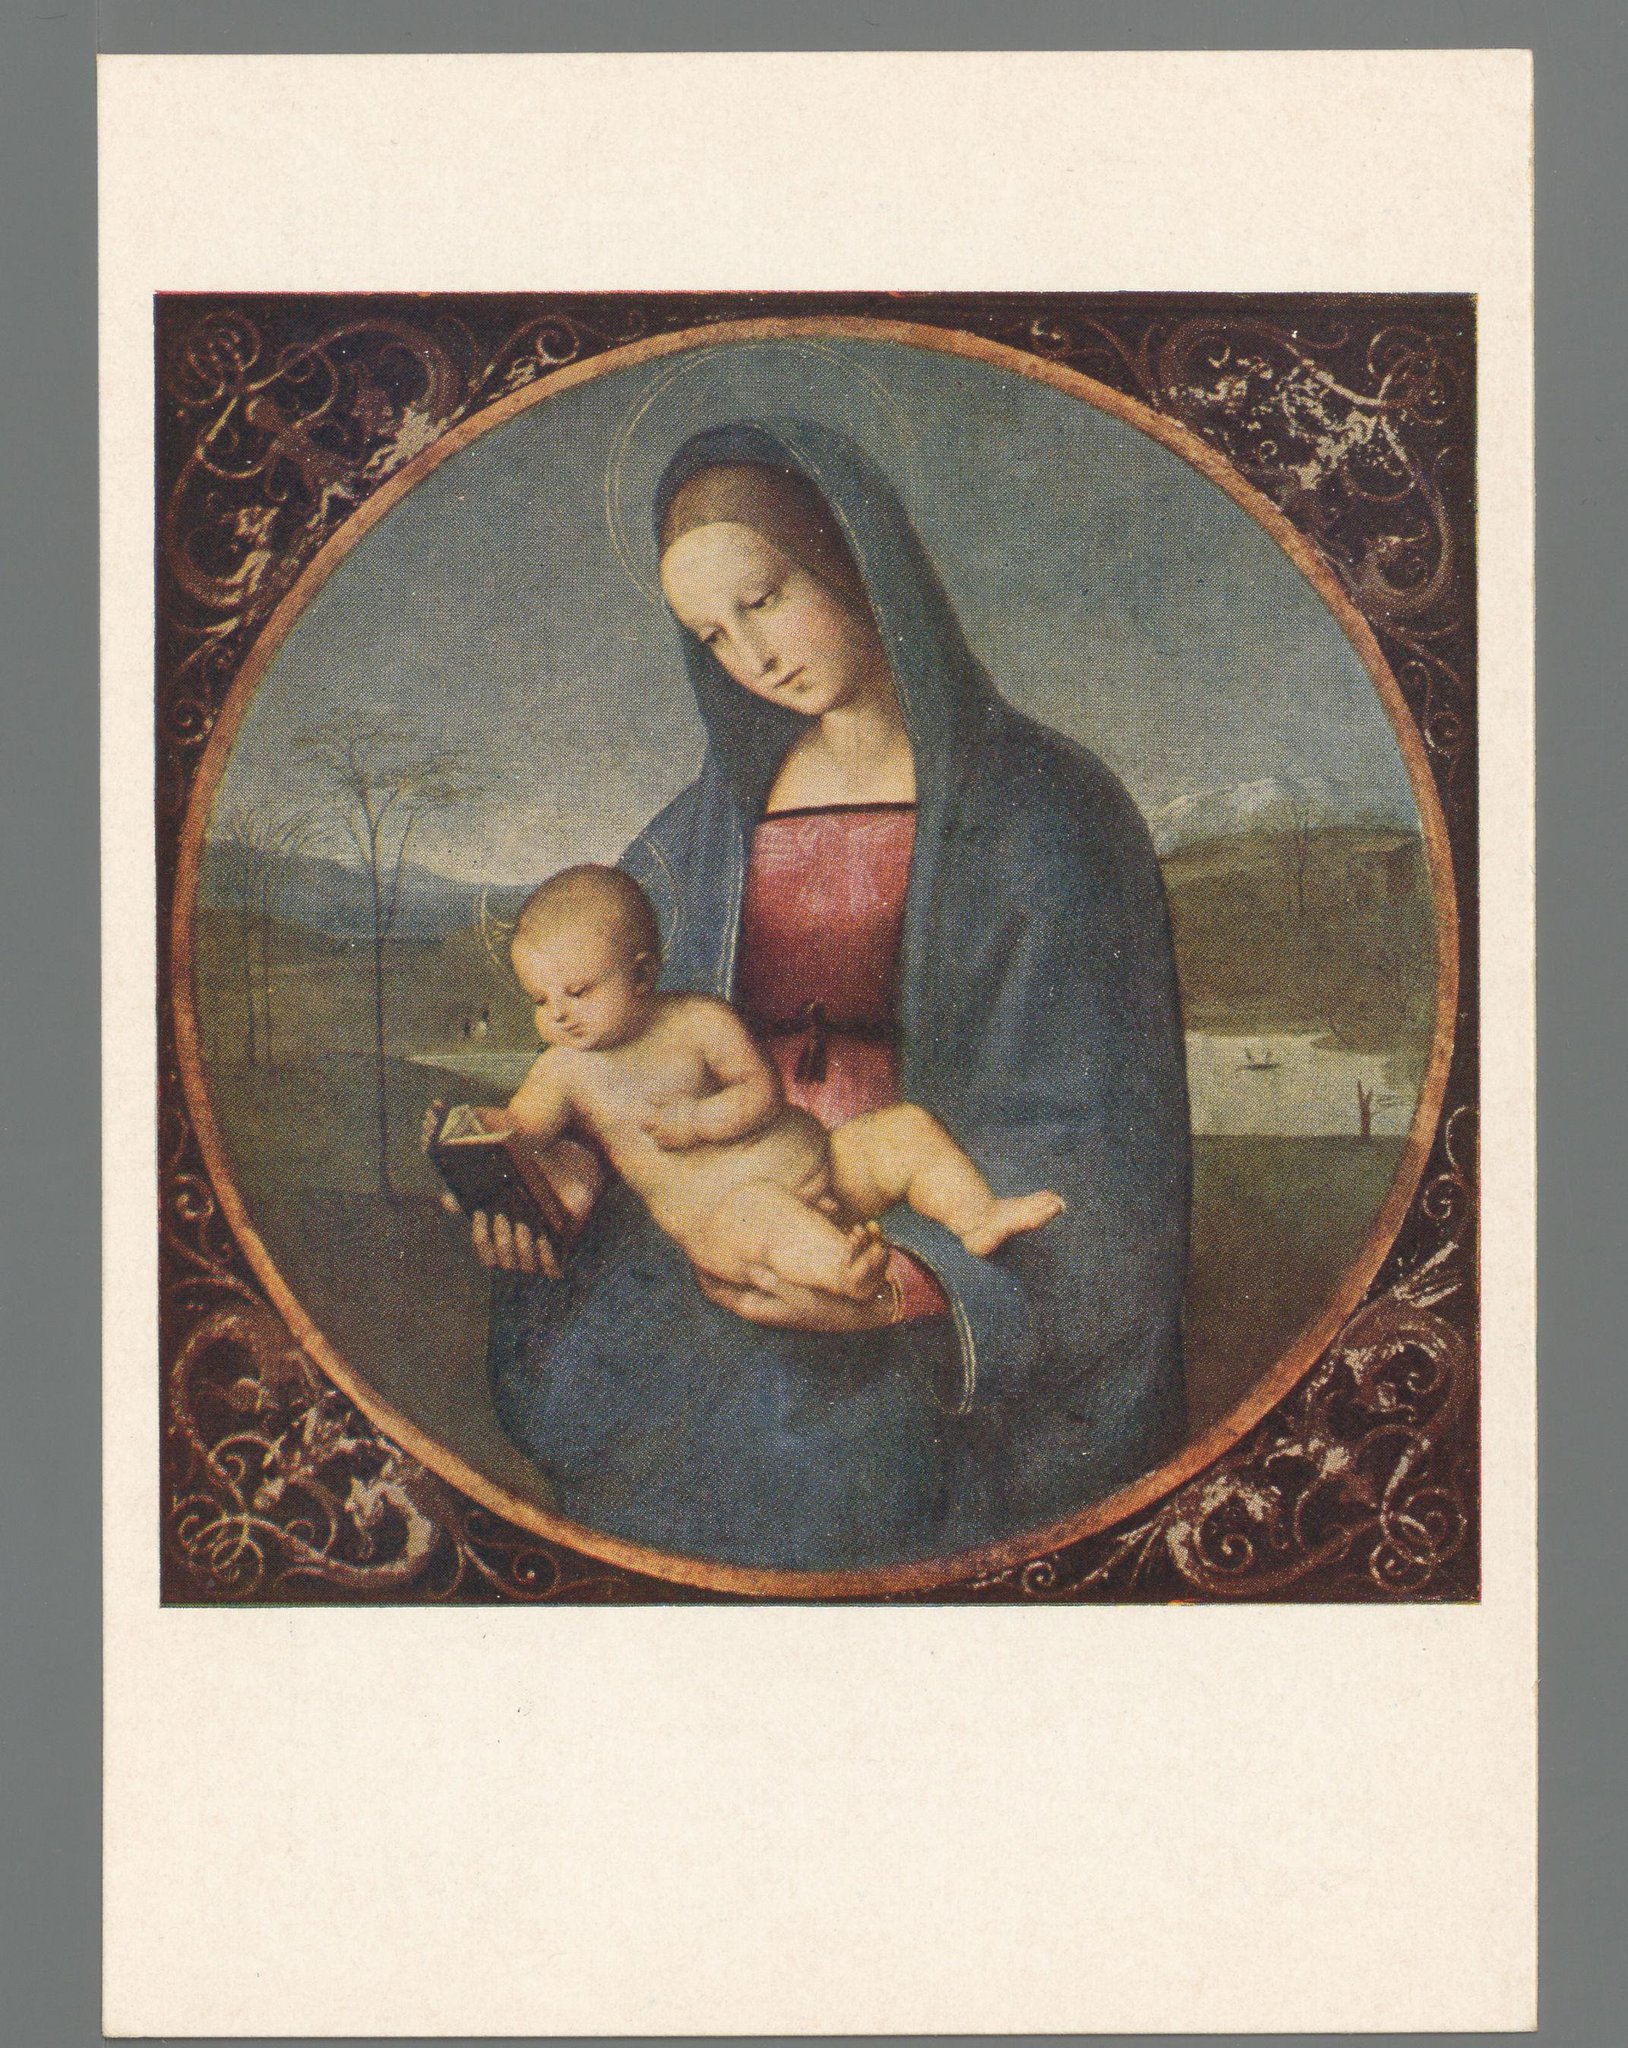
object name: photomechanical print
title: Raphaël (Raffaello Santi). Madone Conestabile / Raphael Santi. Madonna della casa Conestabile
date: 1956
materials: cardboard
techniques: color autotype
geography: moscow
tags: permanent exhibition, museum, picture, painting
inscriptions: date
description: De titel op object staat ook in het Russisch.